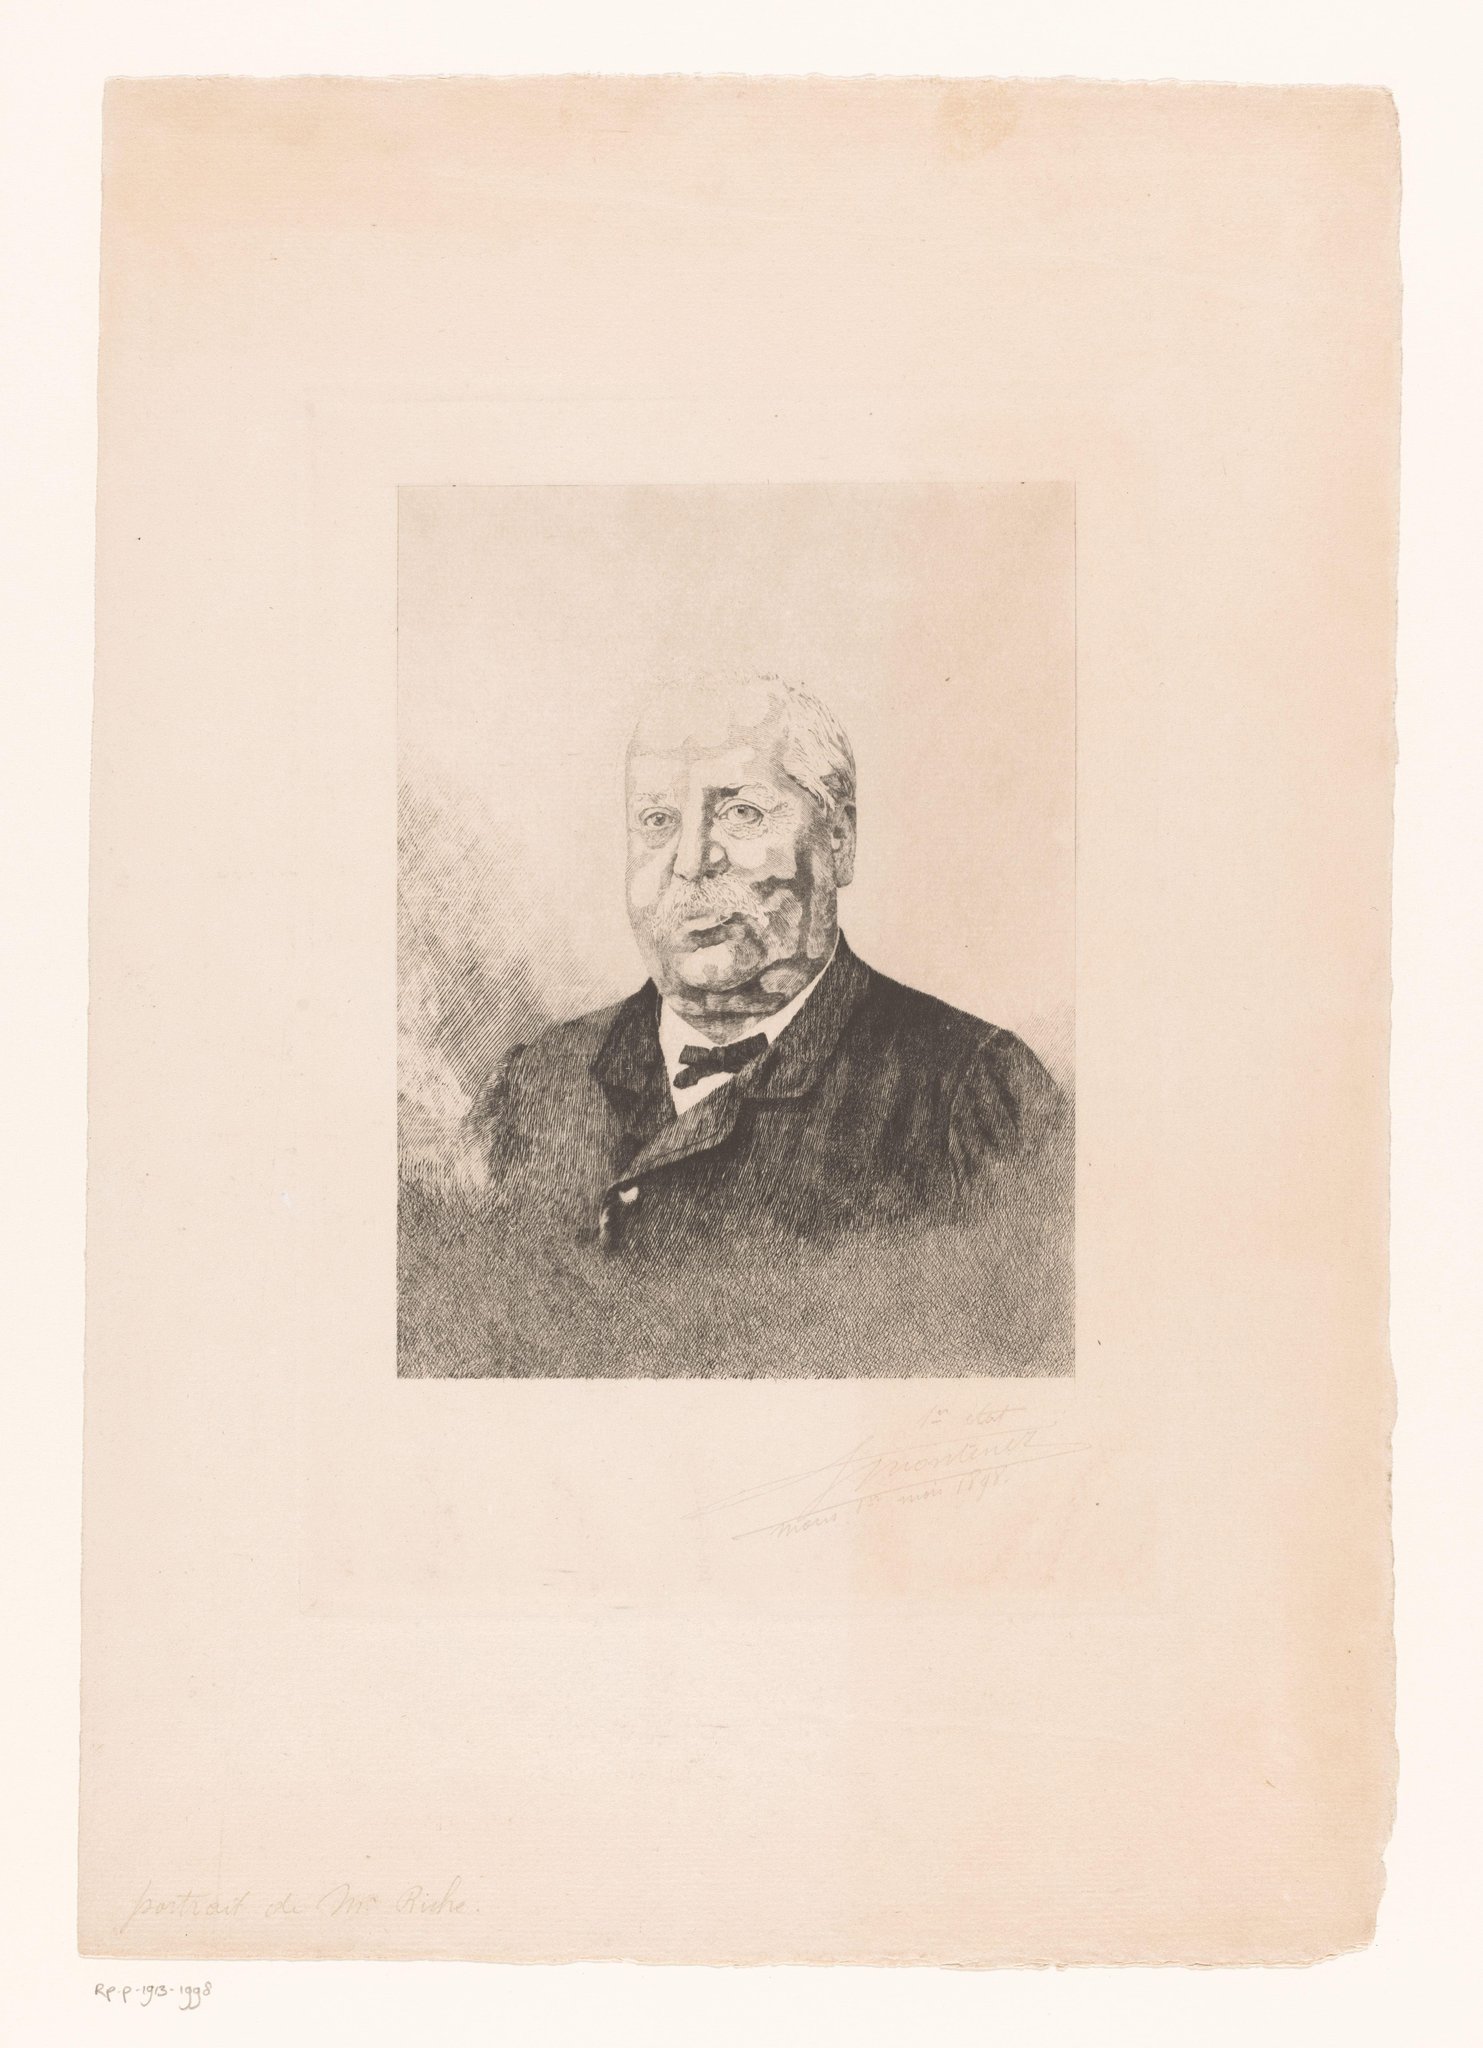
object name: print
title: Portret van een onbekende man, mogelijk Riche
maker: georges montenez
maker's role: print maker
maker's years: 1873-1930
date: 1898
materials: paper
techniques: drypoint, etching, intaglio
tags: adult man, historical persons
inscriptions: inscription: ‘1er état; Mons 1e mois 1898’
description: In de inventaris getiteld: Portret van Mr. Riche.